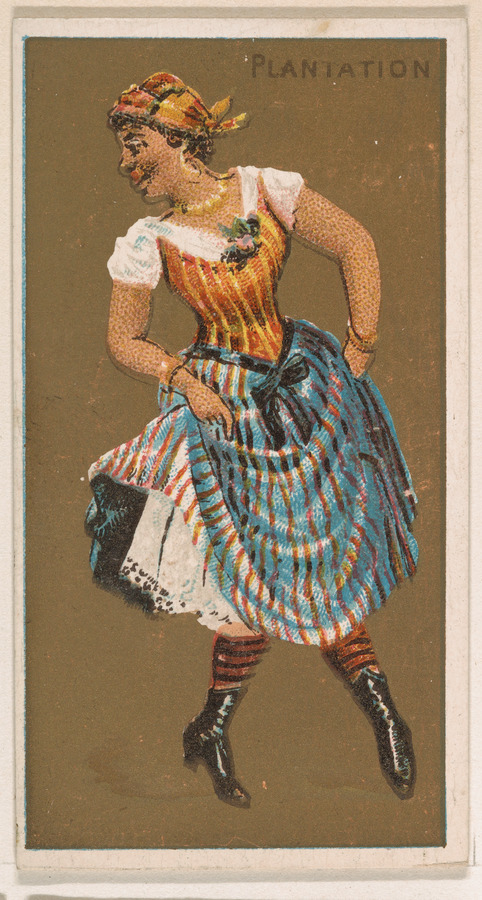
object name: print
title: Plantation, from National Dances (N225, Type 1) issued by Kinney Bros.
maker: kinney brothers tobacco company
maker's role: publisher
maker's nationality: american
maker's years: 1869-2011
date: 1889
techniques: color lithograph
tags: profiles,women,dancing,dancers